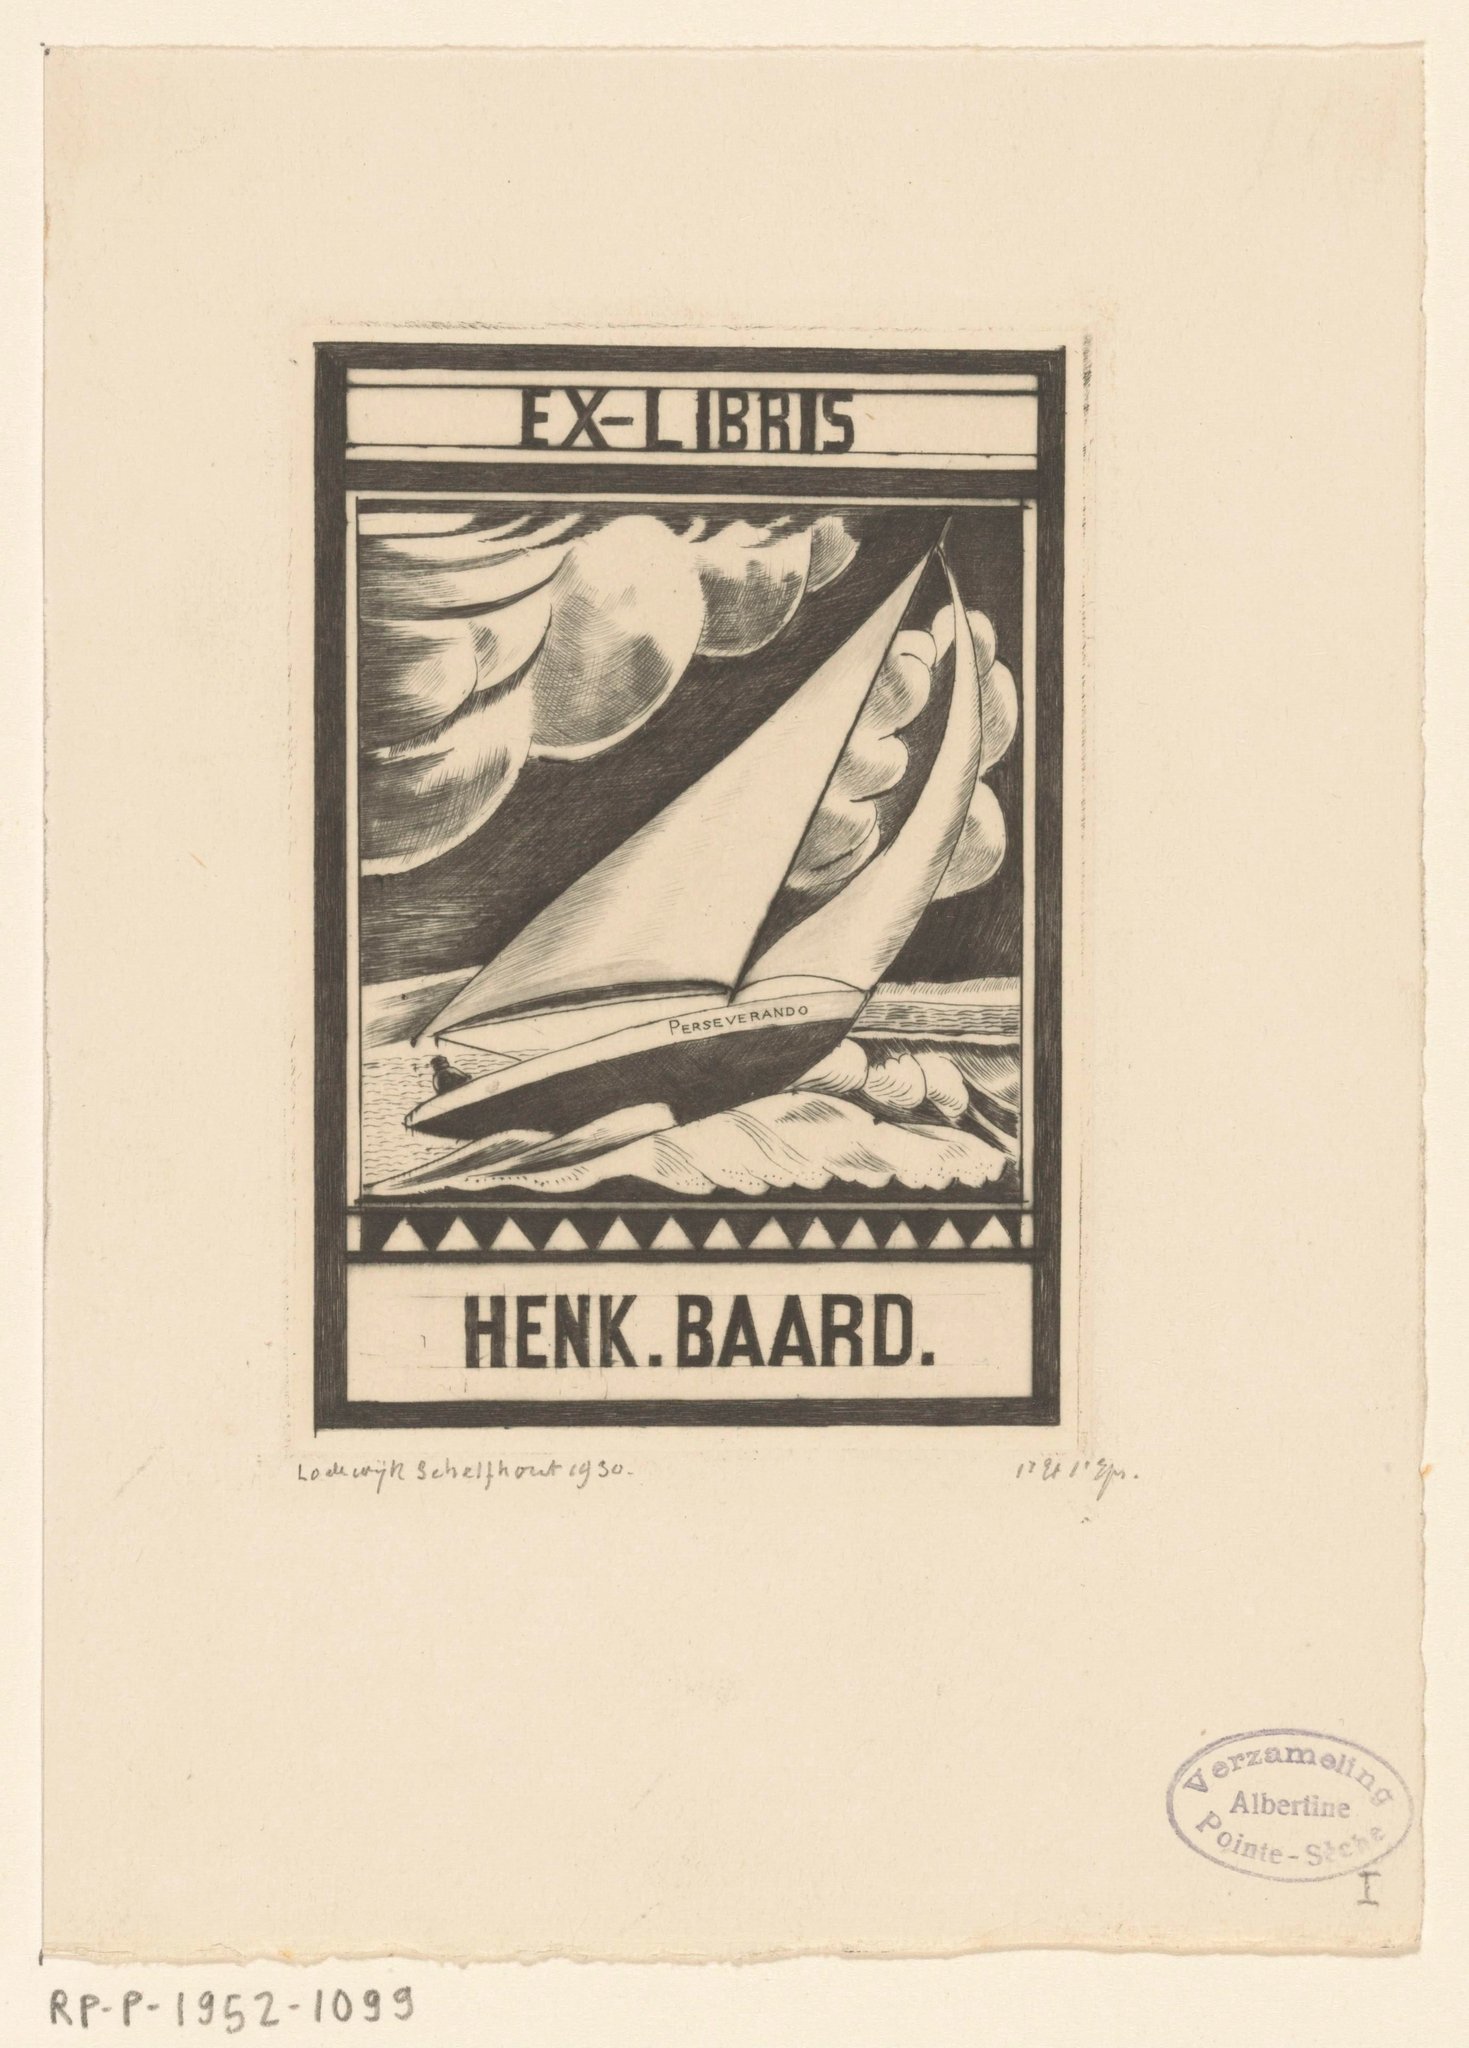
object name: bookplate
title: Ex libris van Henk Baard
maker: lodewijk schelfhout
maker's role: draughtsman, print maker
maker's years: 1881-1943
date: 1930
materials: paper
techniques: drypoint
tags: hendricus petrus baard, sailing-ship, sailing-boat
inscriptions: collector's mark: Lugt 5i, collector's mark: Lugt 2228, inscription: ‘Verz. Albertine / Hilversum.’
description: Een zeilschip met de naam 'Perseverando' op zee.